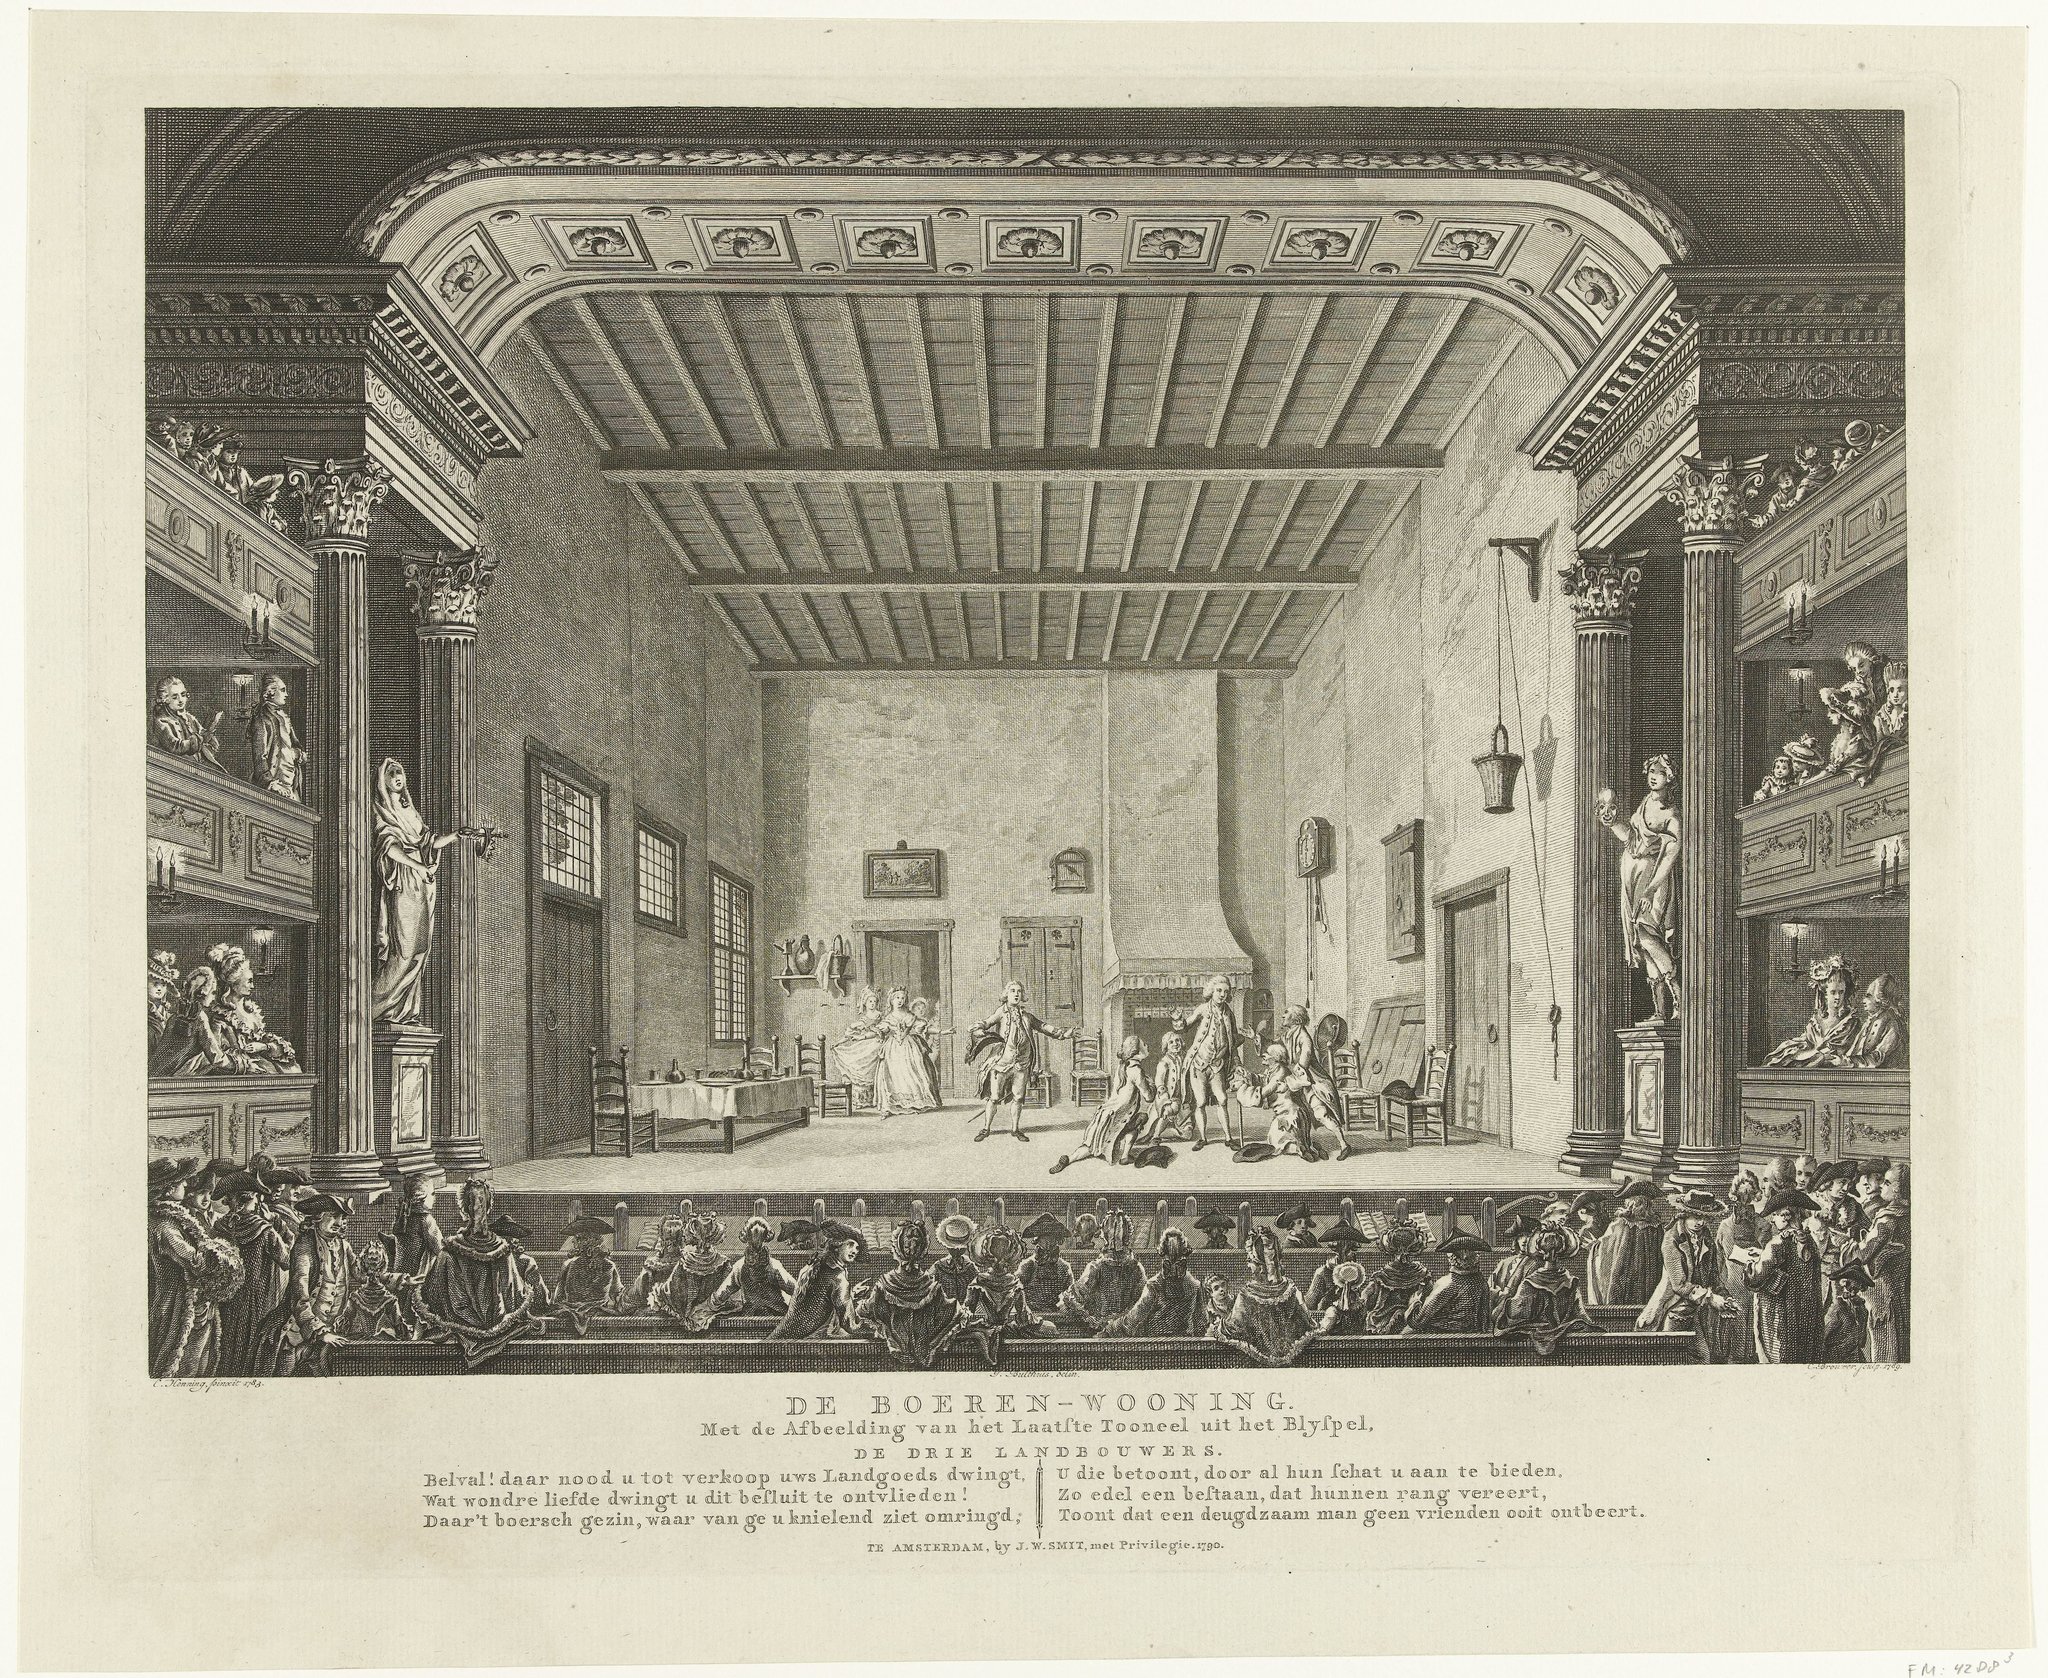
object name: print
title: De boeren-wooning met de Afbeelding van het Laatste Tooneel uit het Blyspel De drie landbouwers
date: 1790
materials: paper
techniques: engraving, etching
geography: netherlands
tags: theatre, theatrical performance, theatre (building)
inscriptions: collector's mark: Lugt 2228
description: Decor met het interieur van de boerenwoning in de Nieuwe Schouwburg te Amsterdam met scène uit toneelstuk De drie landbouwers. In de zaal speelt het orkest en kijkt het publiek toe, ook vanaf de loges. In de marge onder staat een vers in zes regels.